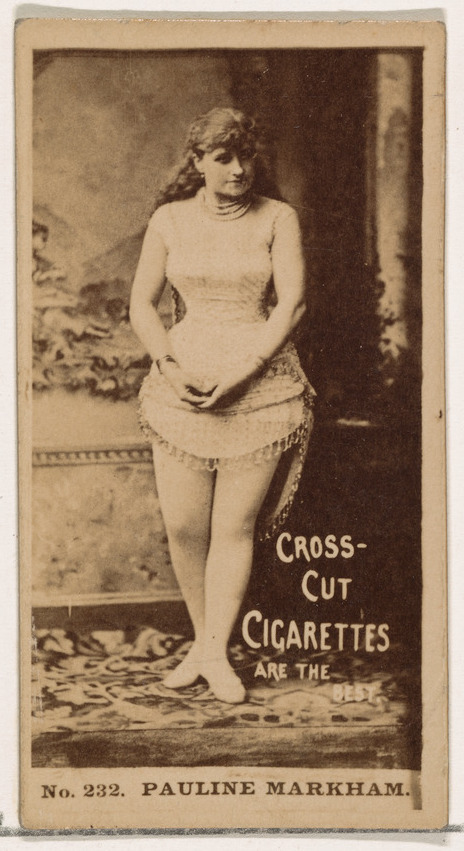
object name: print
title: Card Number 232, Pauline Markham, from the Actors and Actresses series (N145-2) issued by Duke Sons & Co. to promote Cross Cut Cigarettes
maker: w. duke, sons & co.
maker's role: publisher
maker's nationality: american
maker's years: 1870-1920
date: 1880-1889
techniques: albumen silver print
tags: portraits,women,actresses